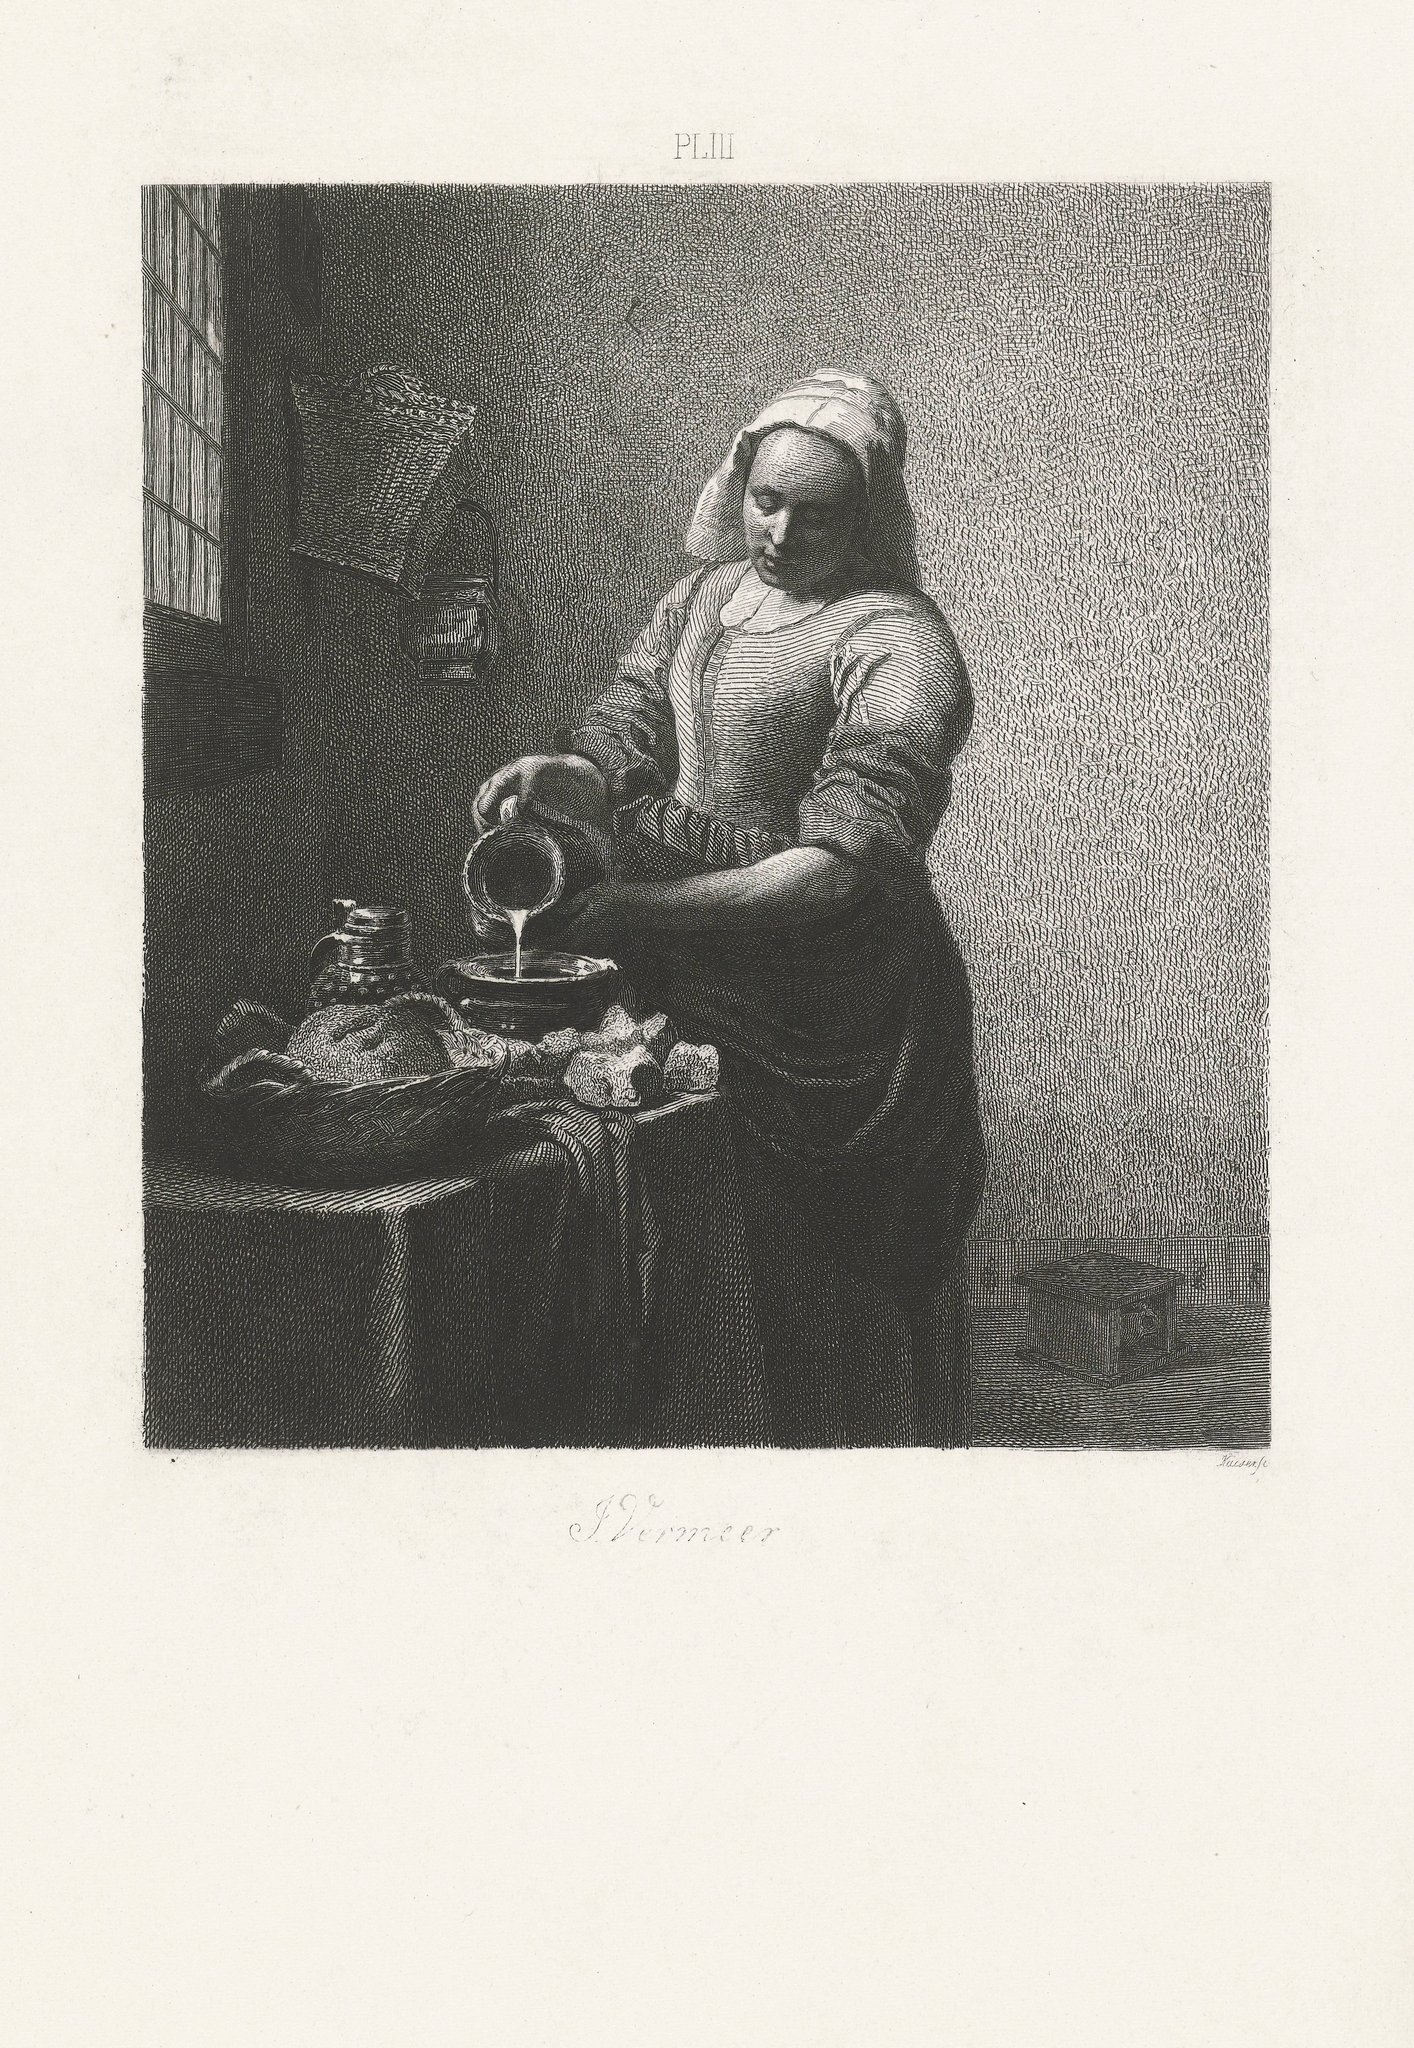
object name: print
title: Hollandse meesters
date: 1823-1900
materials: paper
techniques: etching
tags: milkmaid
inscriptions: collector's mark: Lugt 2228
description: Een melkmeisje schenkt melk in een kom. Rechts van haar een venster. De prent maakt deel uit van een serie van 25 prenten naar Hollandse meesters. Boven de afbeelding: PL III.